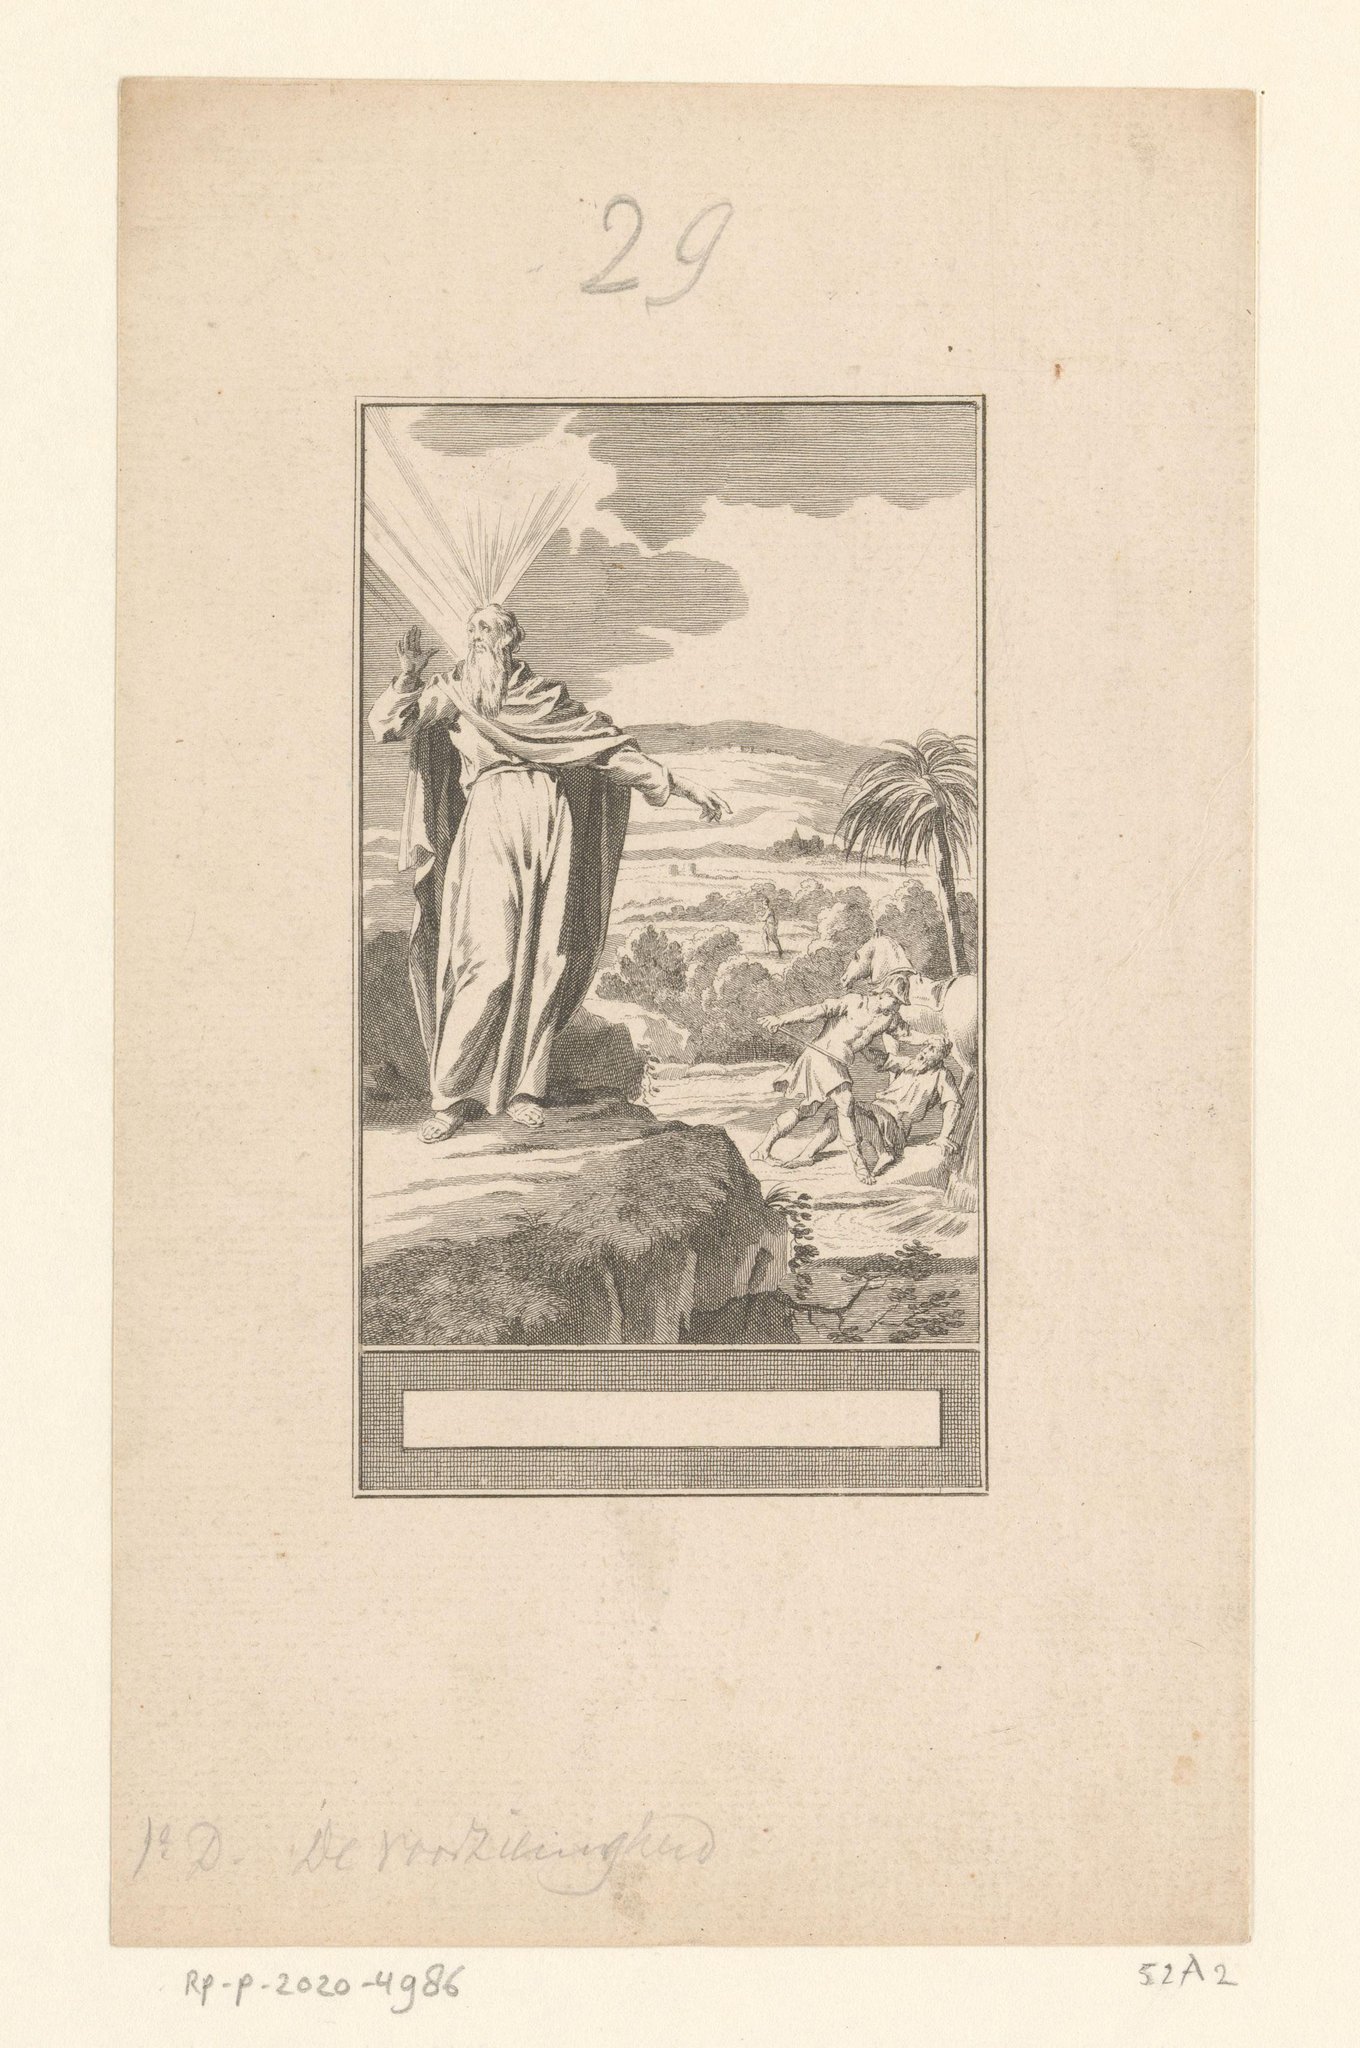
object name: print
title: Mozes wijst op de moord op een oude man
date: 1778-1785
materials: paper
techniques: etching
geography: amsterdam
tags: violent death by sword, forethought, deliberation; 'previdenza', 'providenza' (ripa), moses (not in biblical context); possible attributes: rays of light or horns on his head, rod, tables of the law, murder, robbery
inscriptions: collector's mark: Lugt 2228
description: Latere staat bij: Gellert, Christian Fürchtegott. Fabelen en vertelsels. 3 dln. Amsterdam: Pieter Meyer, 1772-1774, dl. 1 (1772). De prenten bij deze publicatie werden later uitgegeven. De exemplaren uitgegeven door de weduwe Jacobus Loveringh & Johannes Allart tussen 1777 en 1778, de exemplaren uitgegeven door alleen Johannes Allart tussen 1778 en 1785.